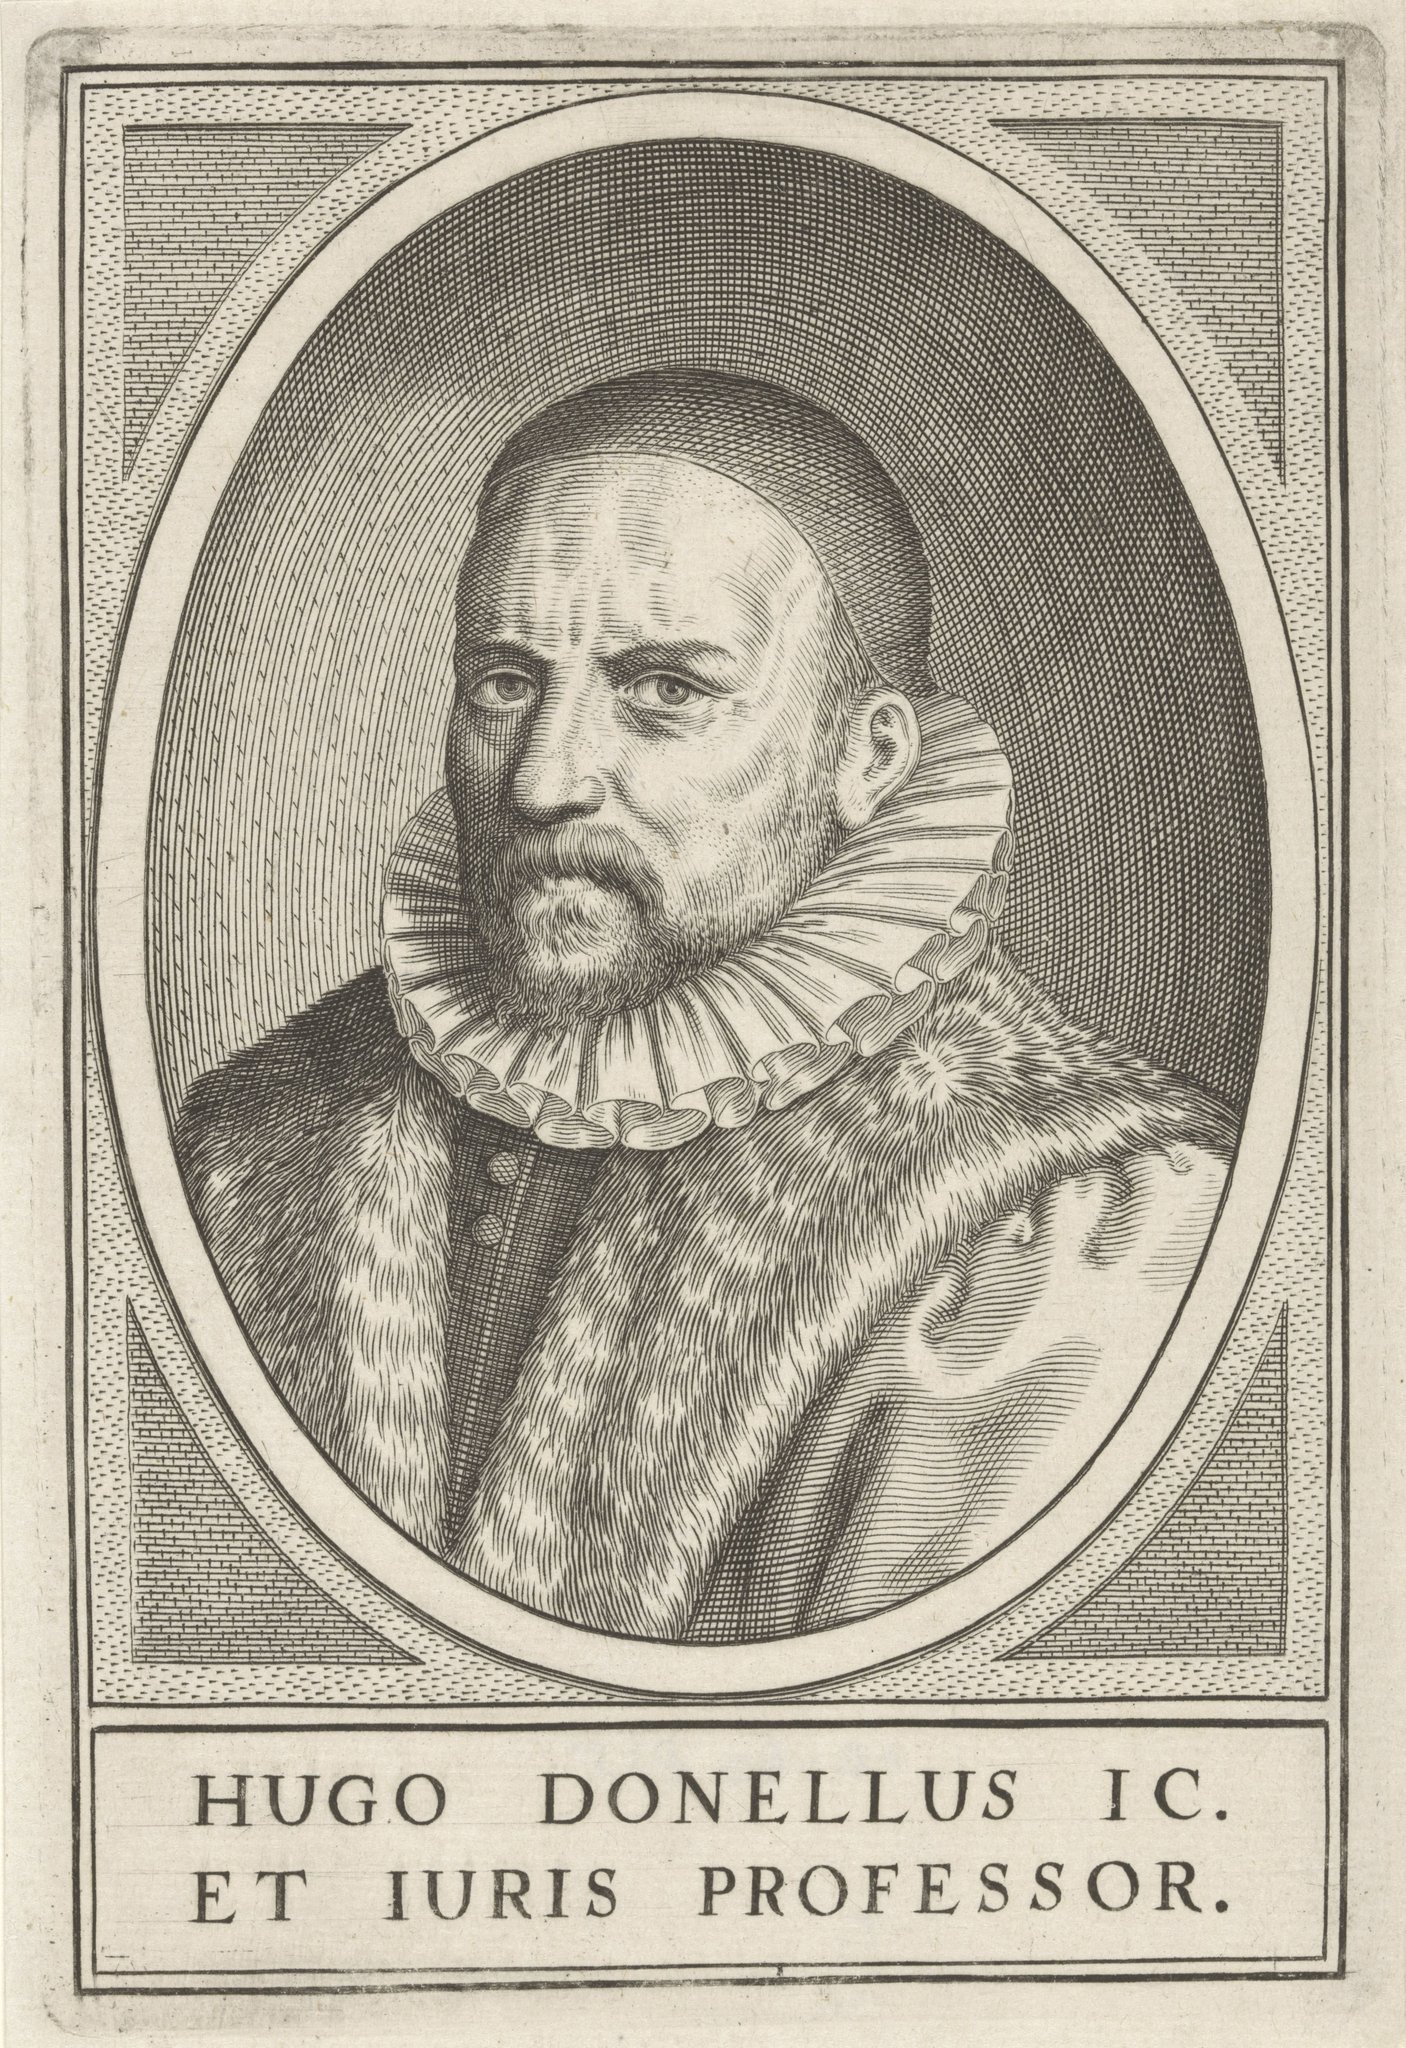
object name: book illustration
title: Portret van Hugo Donellus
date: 1609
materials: paper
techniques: engraving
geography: leiden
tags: châlon-sur-saône, rechtsgeleerde, professor, hugo donellus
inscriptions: collector's mark: Lugt 2228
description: Prent uit: Icones ad vivum delineatæ et expressæ, virorvm clariorvm qui præcipue scriptis Academiam Lvgdvno Batavam illustrarunt. Leiden: Andries Clouck, 1609.